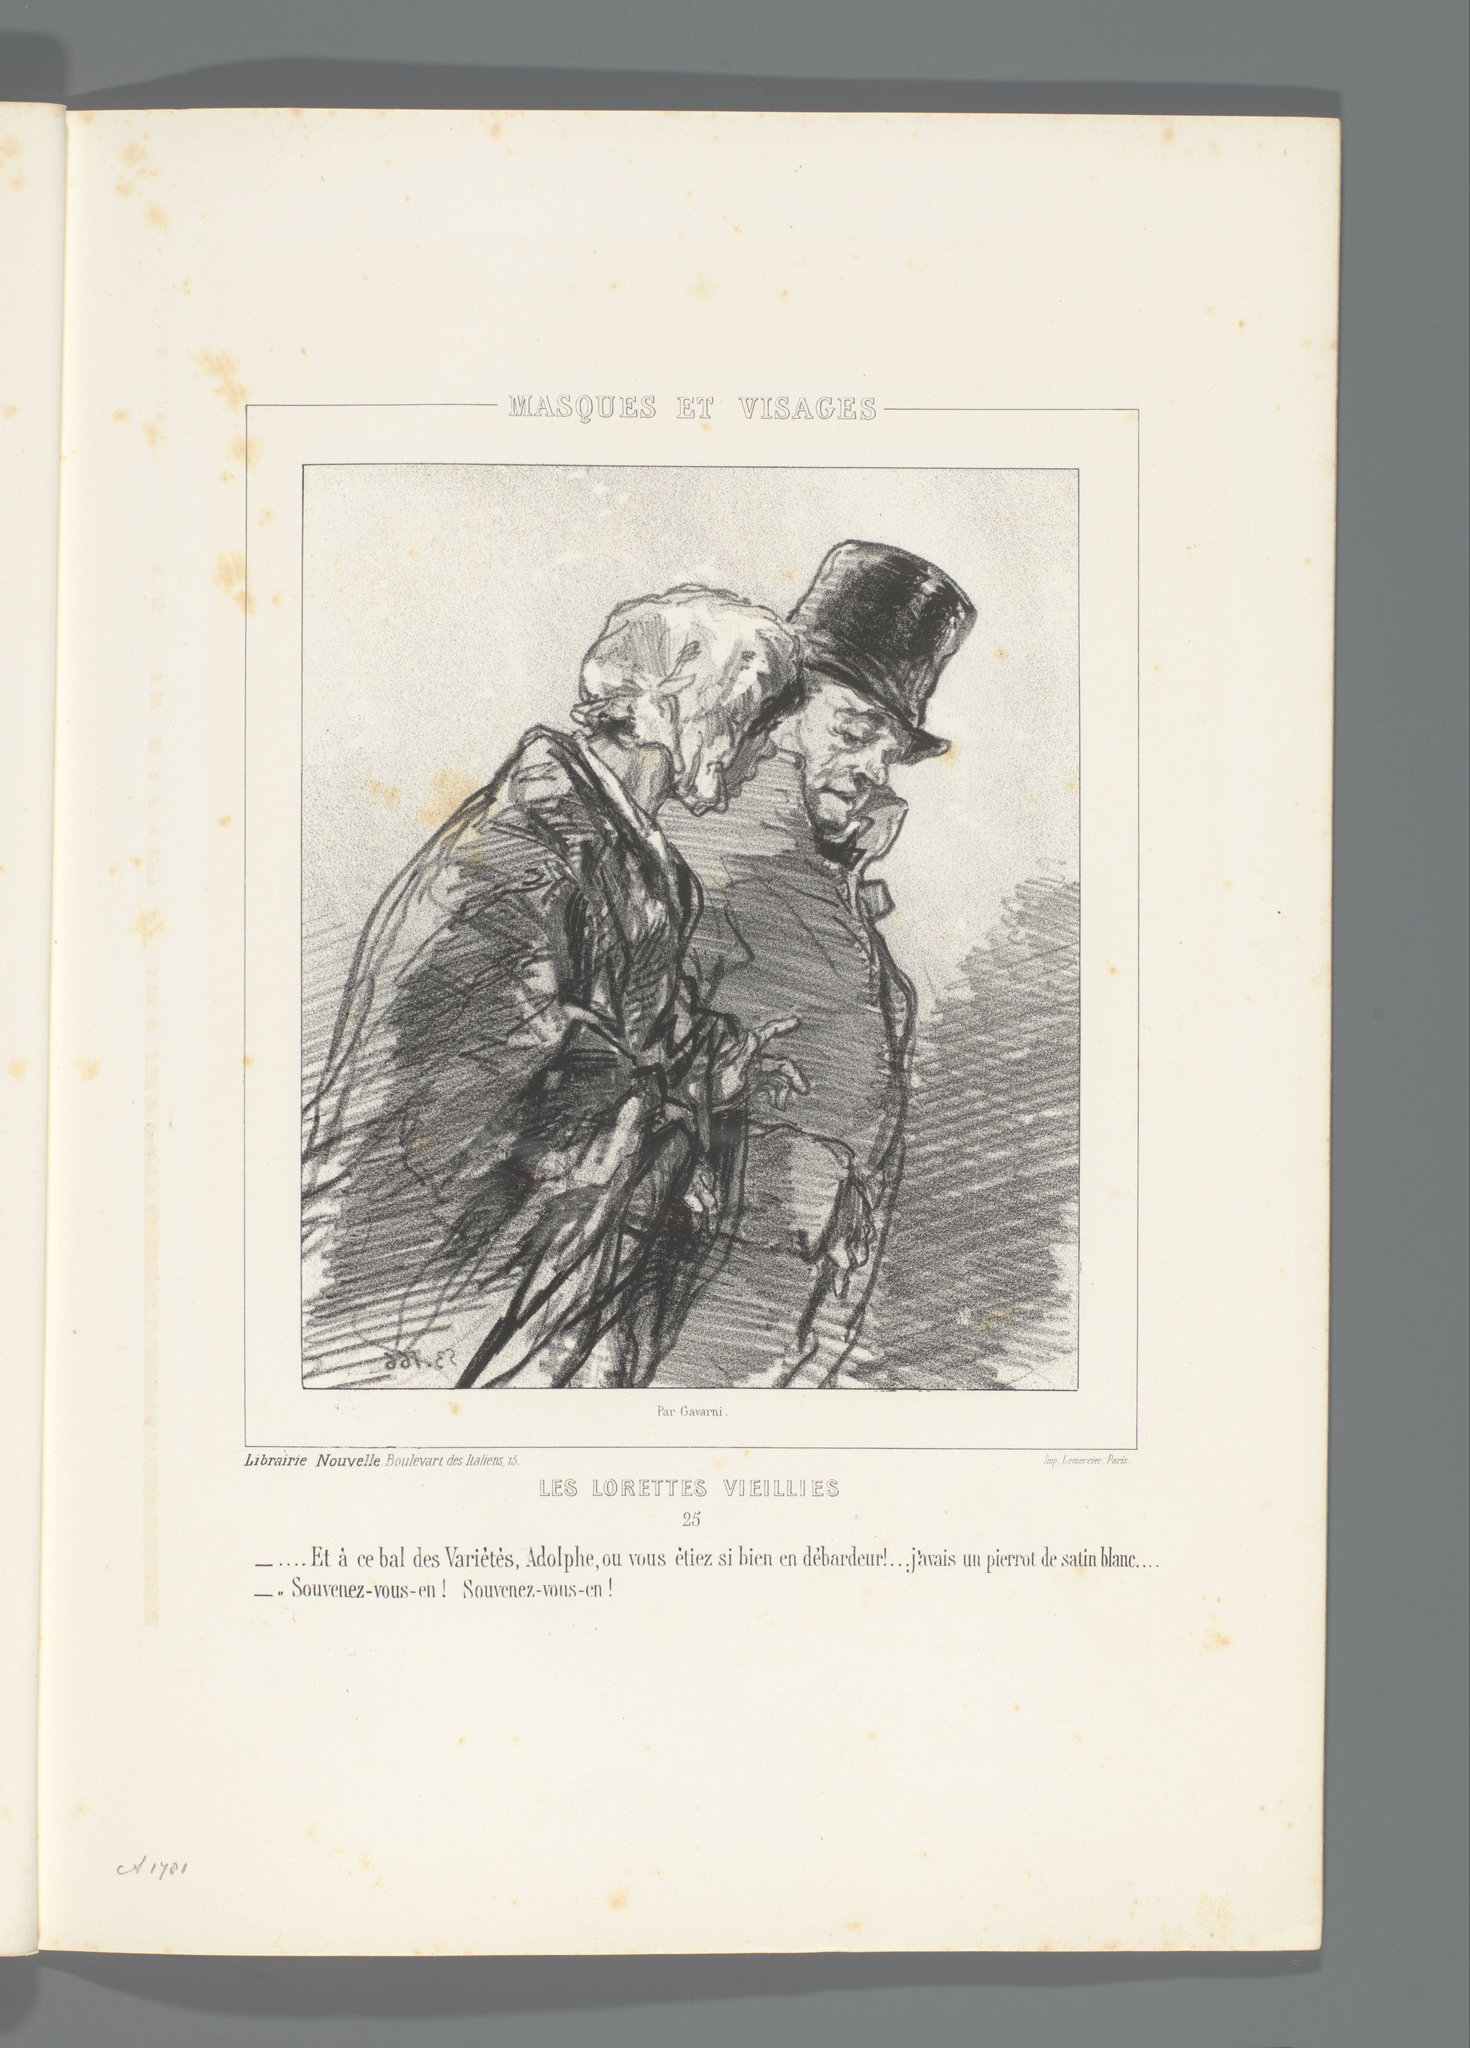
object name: album leaf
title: Masques et visages. Les Lorettes vieillies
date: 1853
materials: paper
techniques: lithograph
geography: paris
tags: old man, old woman, arm in arm (lovers)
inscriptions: collector's mark: Lugt 964